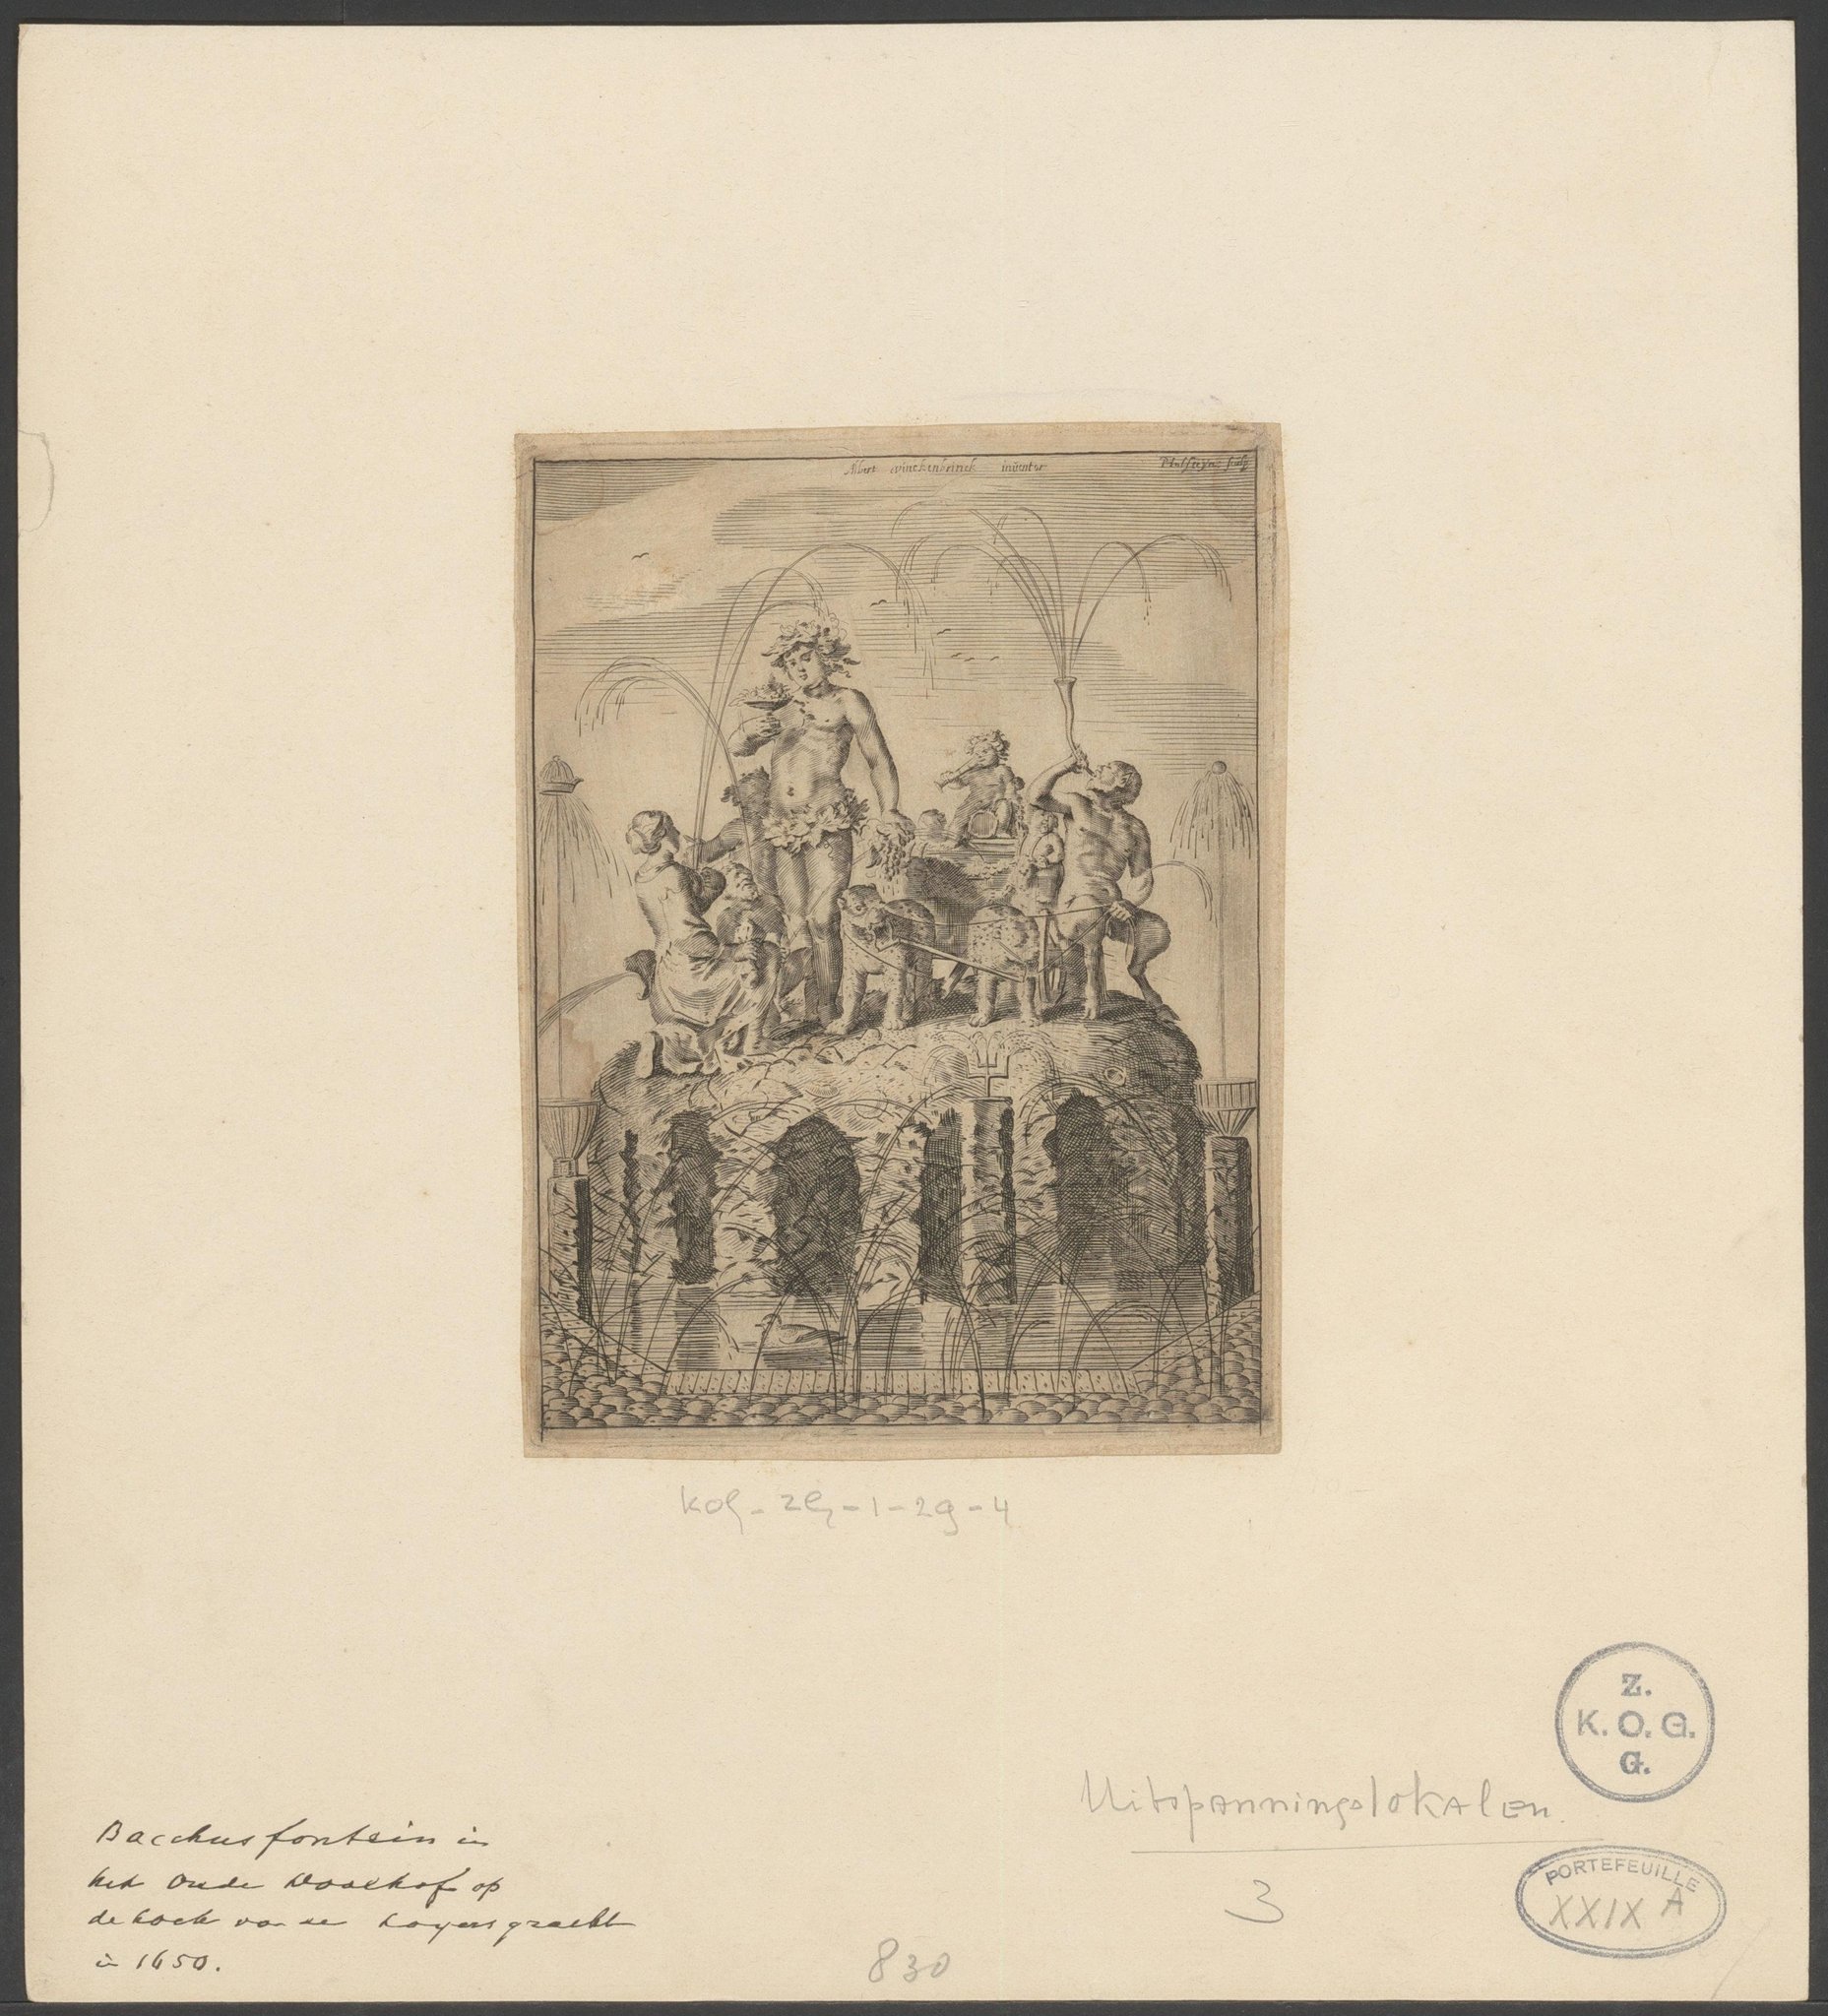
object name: print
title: Bacchus-fontein op de plaats van de Oude Doolhof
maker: pieter holsteyn (ii)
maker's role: draughtsman, print maker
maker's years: 1614-1673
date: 1648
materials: paper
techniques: engraving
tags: triumph of bacchus and ariadne, ornamental fountain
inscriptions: stamp, collector's mark: Lugt 1641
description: Prent waarschijnlijk uit: Verklaringe van verscheyden kunst-rijcke wercken en hare beweginghe, door orlogie-werck ghedreven (...) Alles te sien in 't Oude Doolhof tot Amsterdam (...). Amsterdam: Tymen Houtbaeck, 1648.